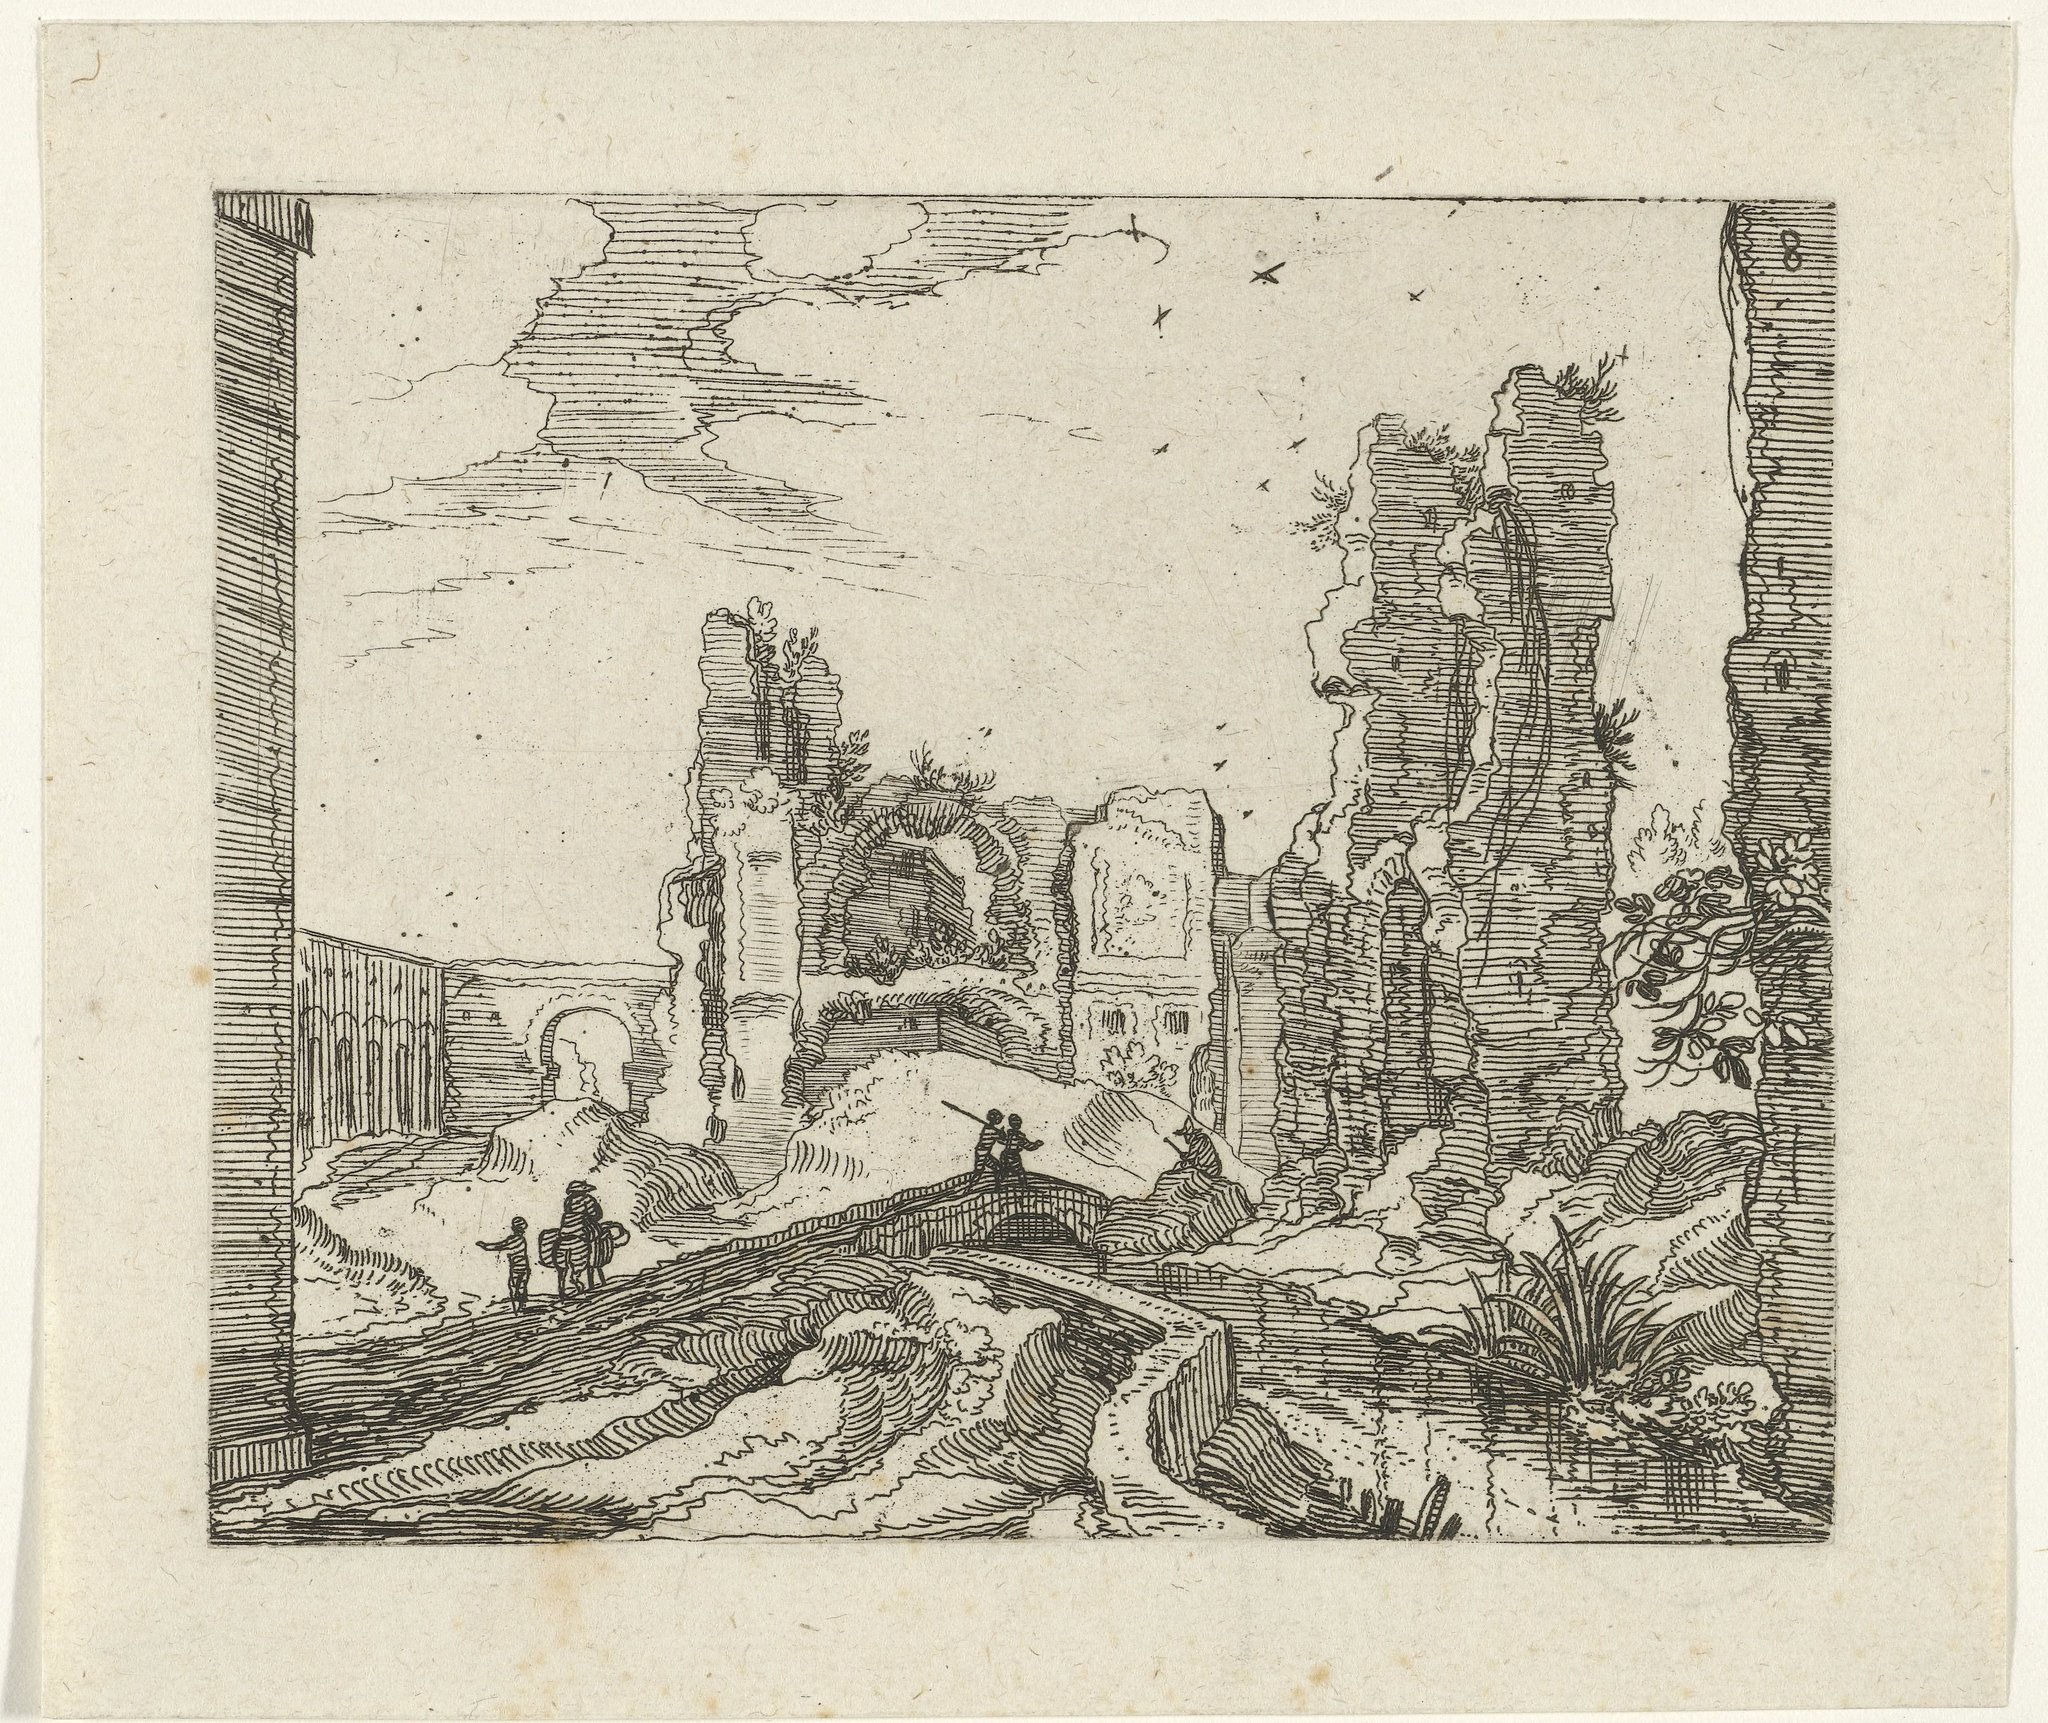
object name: print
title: Landschap met poort en ruïne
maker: guilliam van nieulandt (ii)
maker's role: draughtsman, print maker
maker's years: 1584-1635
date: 1594-1618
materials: paper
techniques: etching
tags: landscape with ruins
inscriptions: collector's mark: Lugt 240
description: Aan het water liggen begroeide ruïnes, wellicht de Porta Furba. Links een poort. Links op de voorgrond een weg met een bereden ezel en een wandelaar. Op de brug lopen twee figuren. Prent uit een serie Romeinse ruïnes.